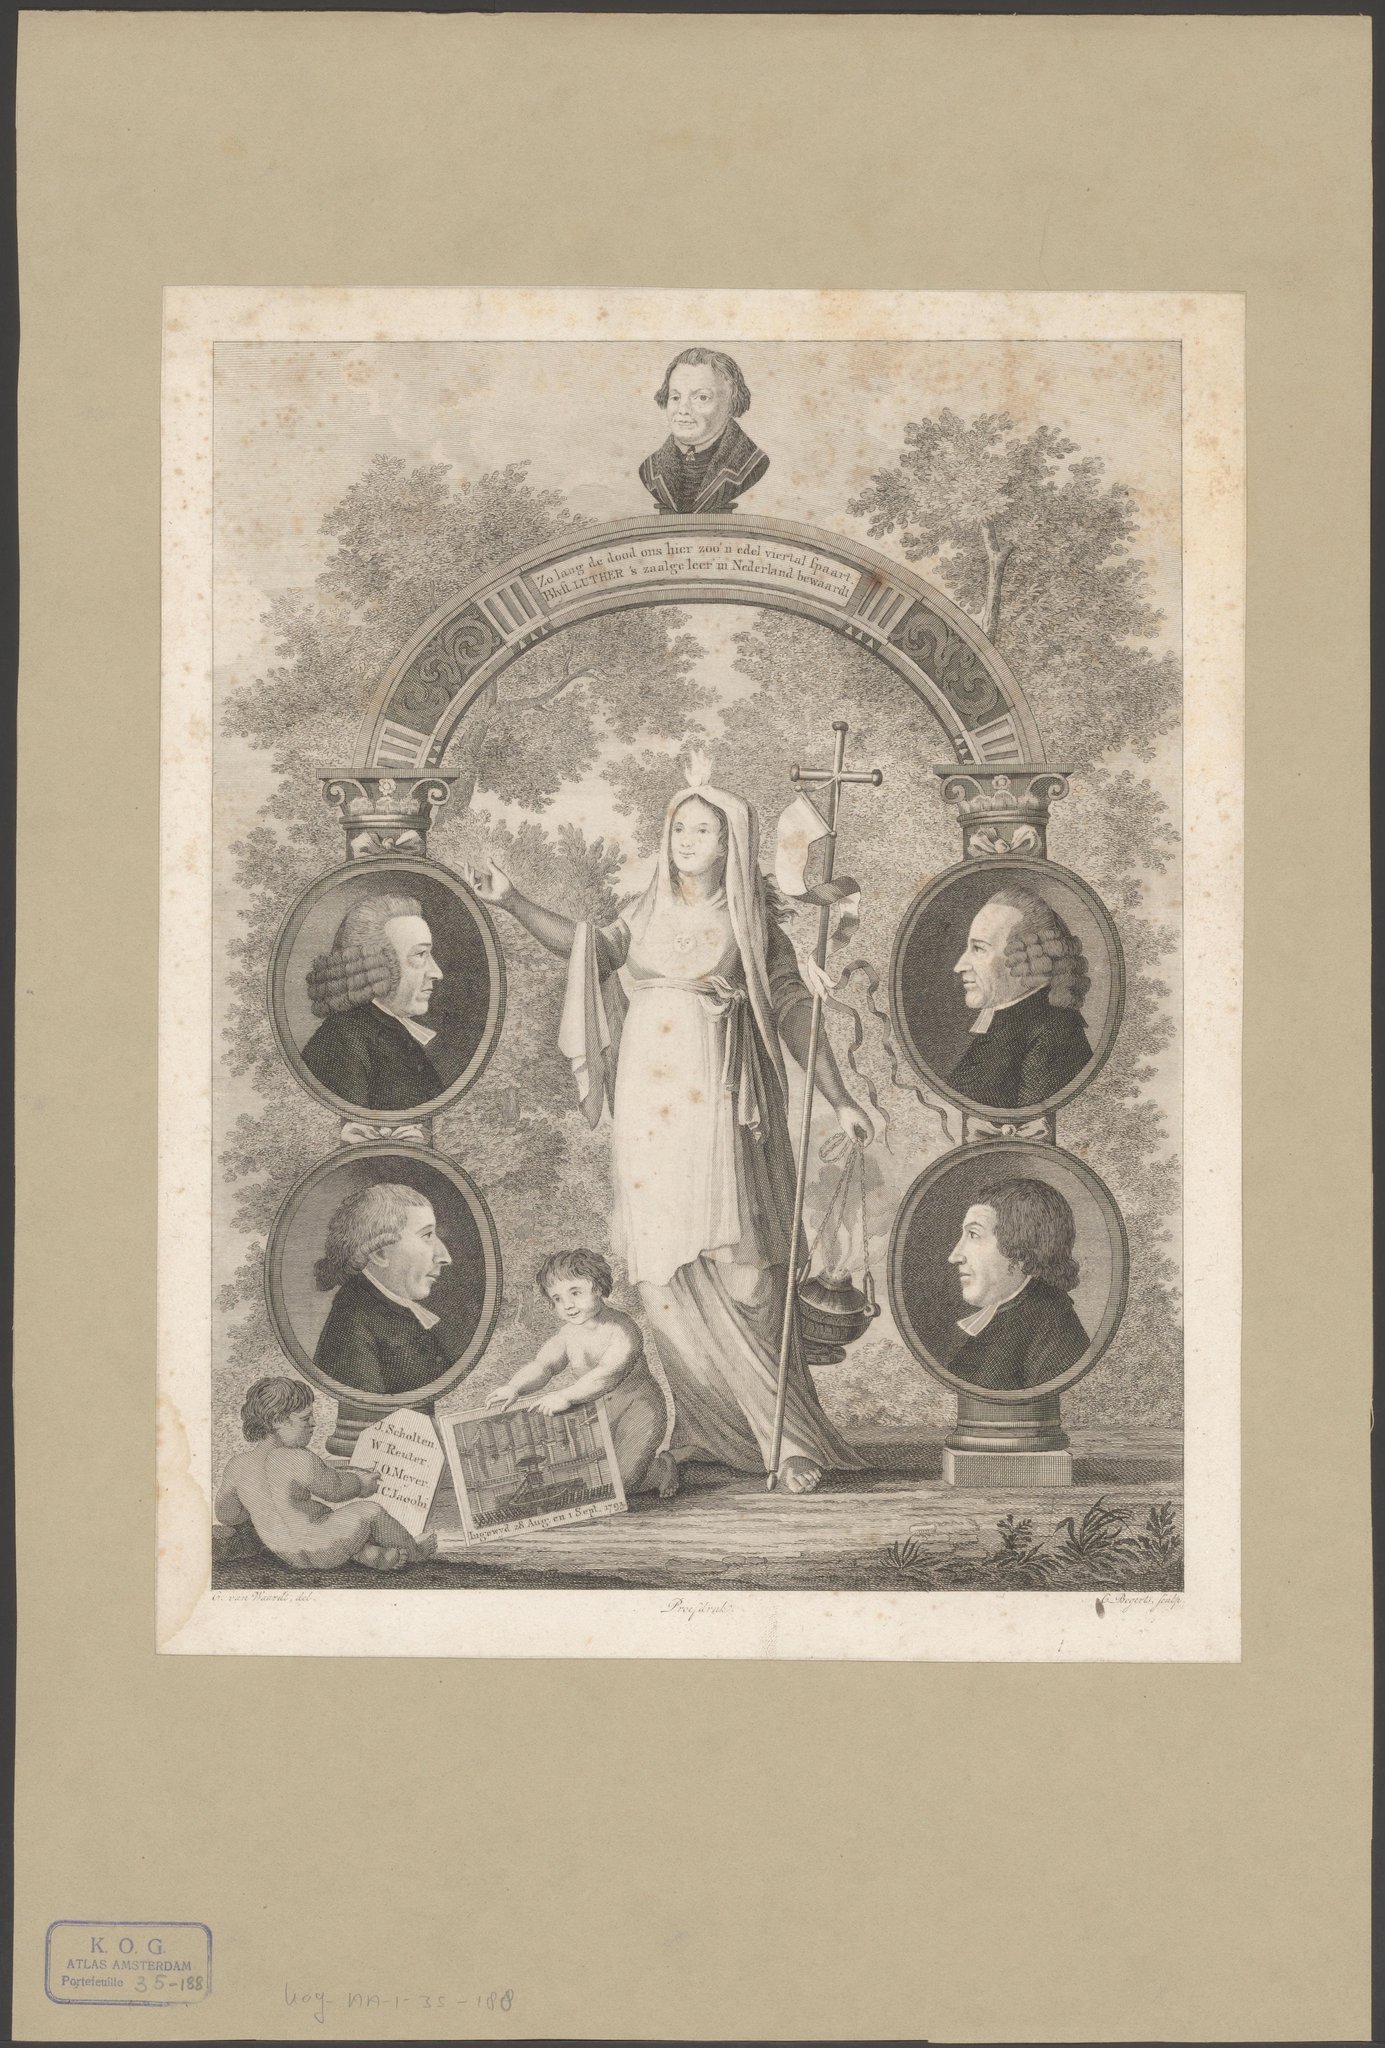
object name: print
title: Allegorische voorstelling met portretten van vier Lutherse predikanten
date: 1793-1817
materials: paper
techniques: engraving, etching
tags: amsterdam, the hague, priest, martin luther, faith, 'fides'; 'fede', 'fede catholica', 'fede christiana', 'fede christiana catholica' (ripa) ~ one of the three theological virtues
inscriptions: collector's mark: Lugt 1641b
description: In het midden staat Geloof onder een boog met daarop een buste van Martin Luther. Hier omheen de portretten van Isaac Scholten, Wilhelm Reuter, Johann Otto Meyer en Jan Coenraad Jacobi. Onderwerpsrubriek binnen de Atlas Amsterdam: Kerkwezen: Ev. Lutherse Gemeente: Herst. Ev. Luth. Gemeente.